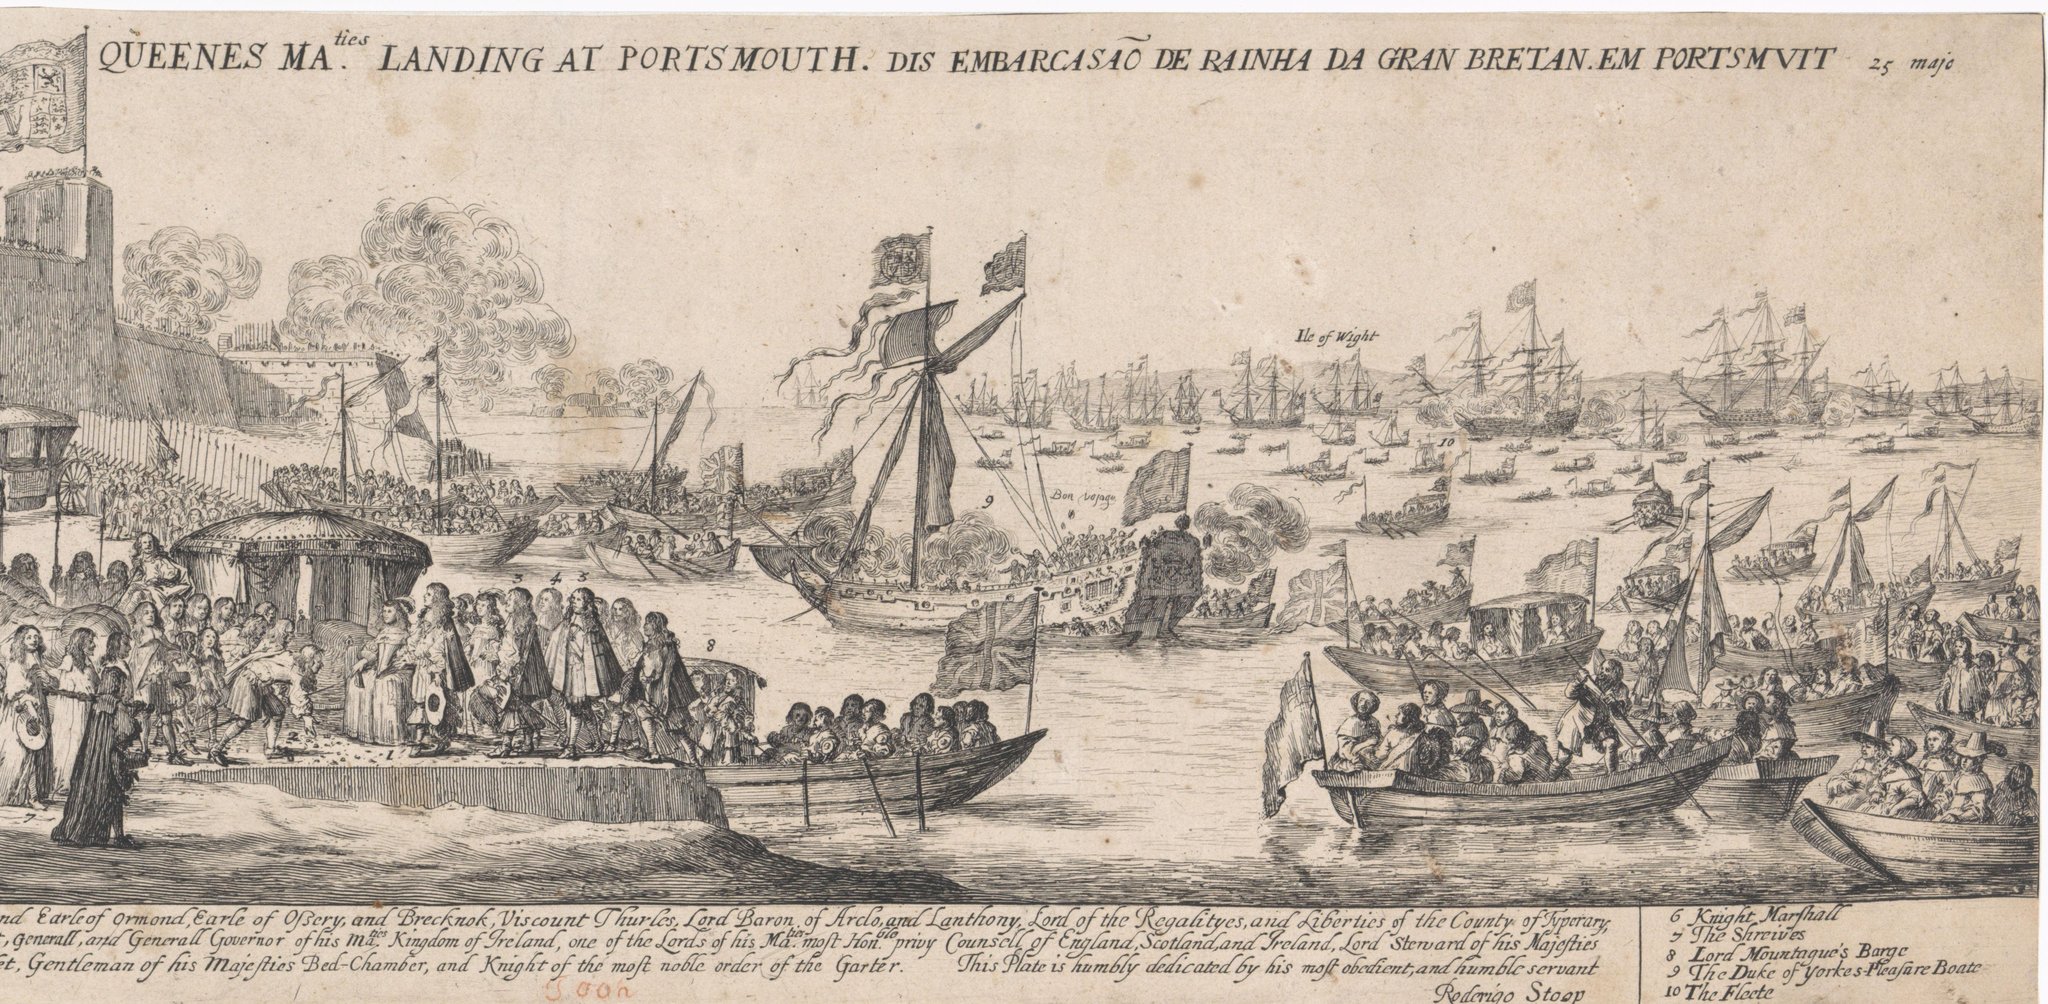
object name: print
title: Aankomst van koningin Catharina van Braganza in Portsmouth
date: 1662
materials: paper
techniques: engraving, etching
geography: england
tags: jacobus ii (koning van engeland en schotland), catharina van bragança, edward montagu (1st earl of sandwich), eerste hertog van ormond butler, sailing-ship, sailing-boat, triumphal entry and public reception, pageant, 'entrée solennelle', 'joyeuse entrée', portsmouth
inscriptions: collector's mark: Lugt 2228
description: Koningin Catharina van Braganza arriveert op 25 mei 1662, begeleidt door de hertog van York, in de haven van Portsmouth. Op het water kleine en grote schepen. Links wachten soldaten en koetsen op de aankomst van de koningin. Onderaan in de marge een legenda met nummers, die verwijzen naar personen en schepen in de voorstelling. Prent maakt deel uit van een serie over de reis van Catharina van Braganza van Portugal naar Londen, waar zij met Karel II van Engeland trouwde, in 1662.